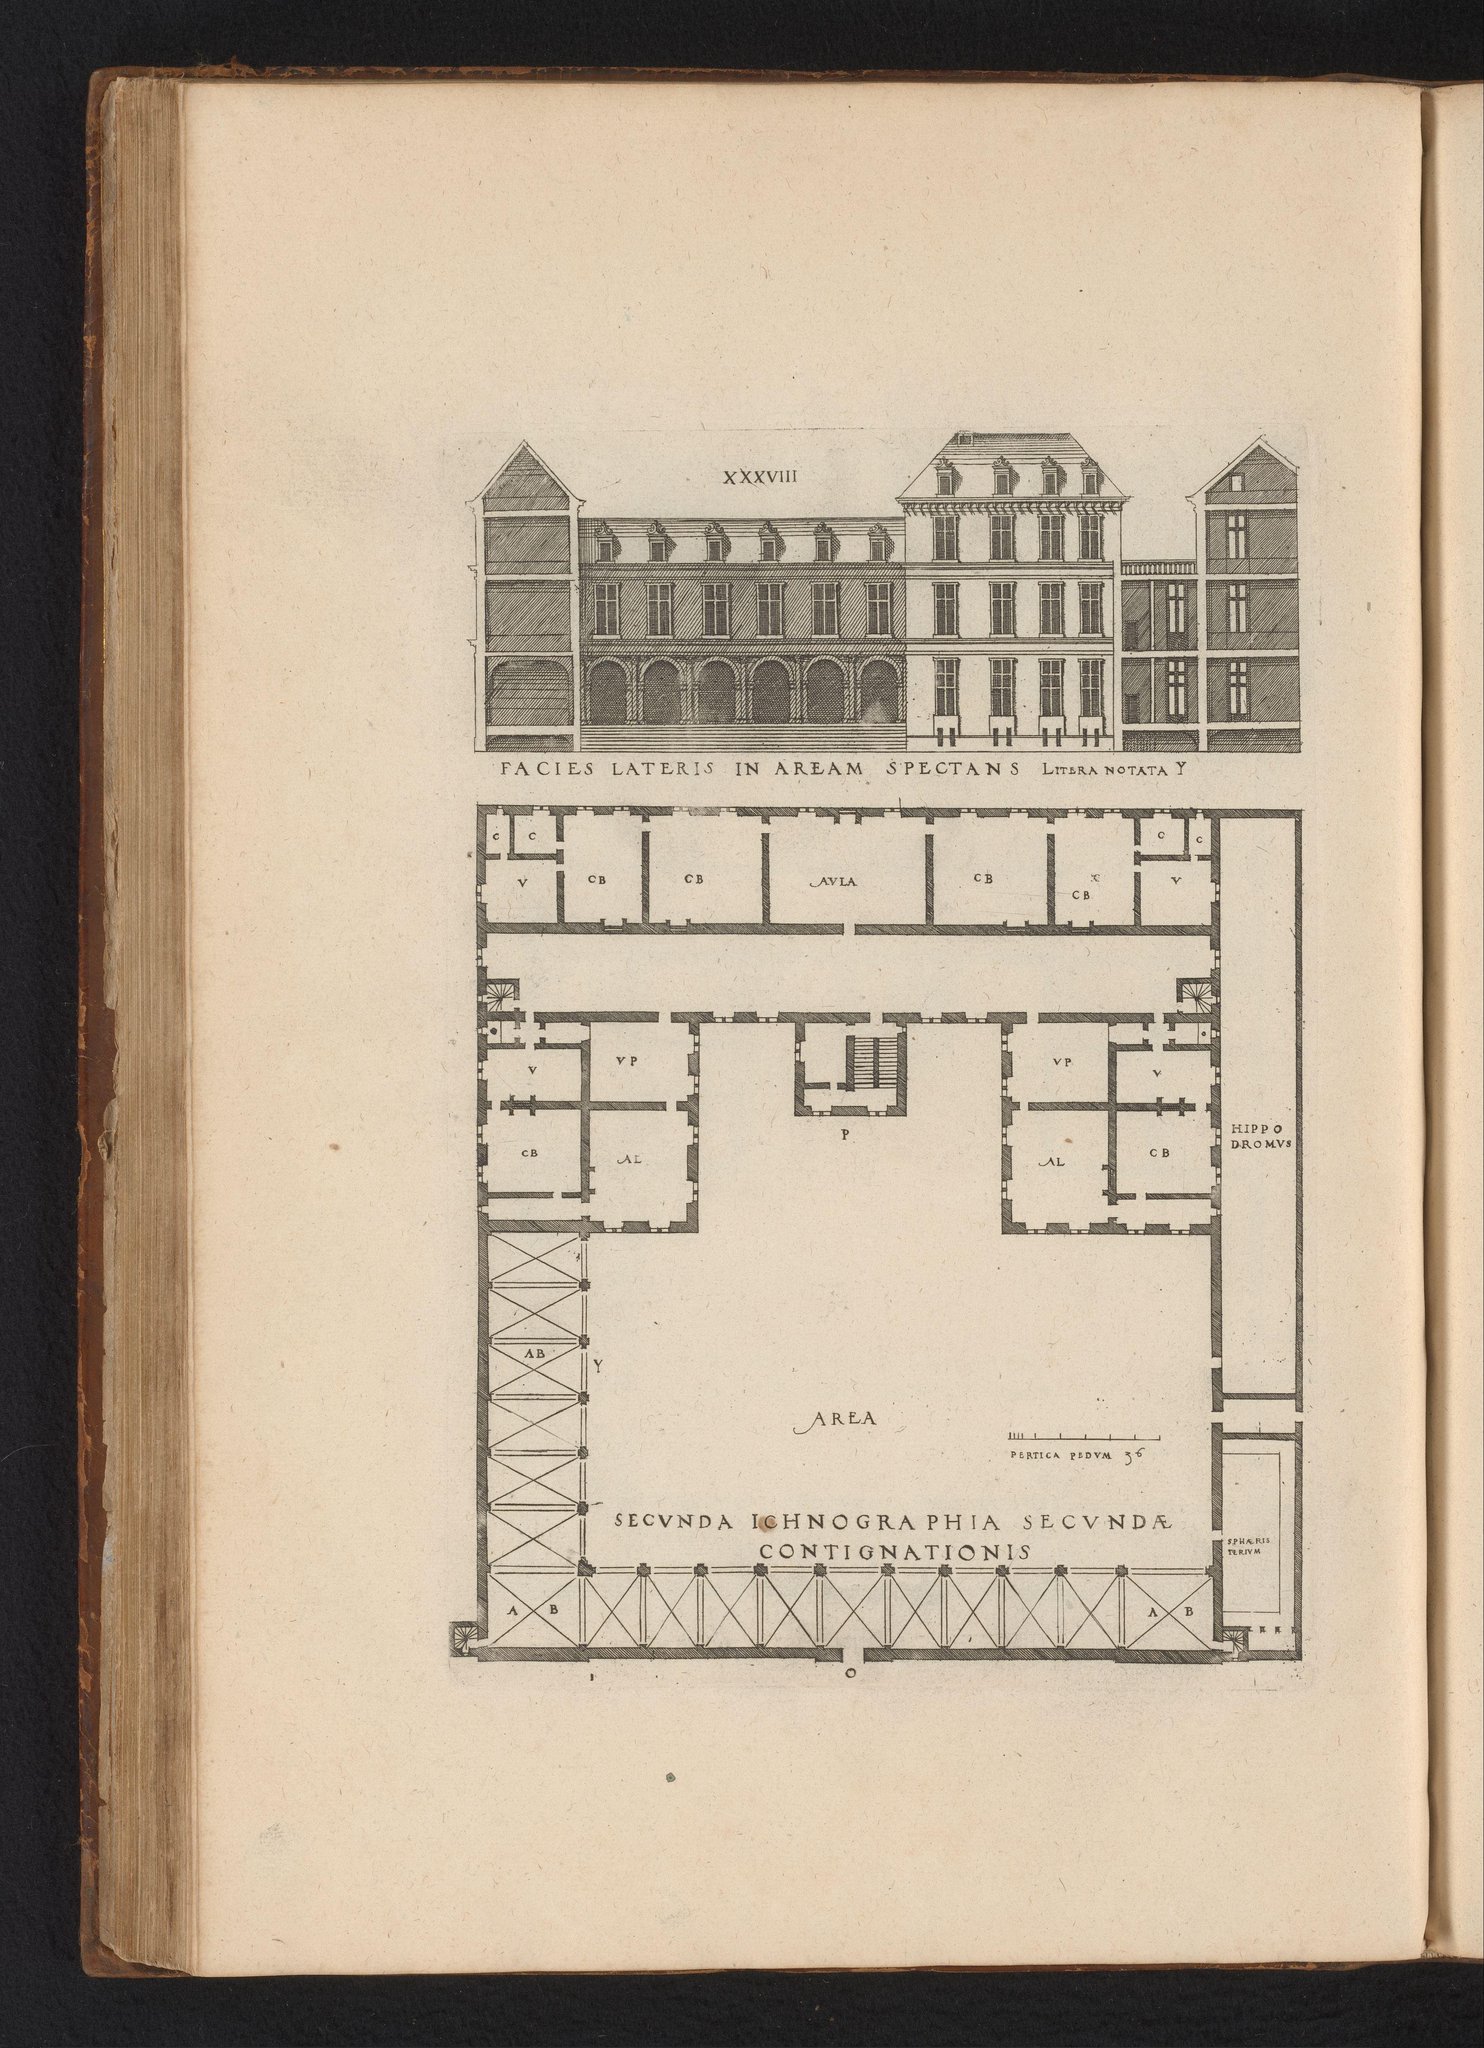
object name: ornament print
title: Doorsnede en plattegrond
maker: jacques androuet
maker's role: draughtsman, print maker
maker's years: 1515-1584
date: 1559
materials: paper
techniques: etching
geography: paris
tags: façade (of house or building), section ~ architectural design or model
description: Doorsnede en plattegrond. Aanzicht en plattegrond van architectuur. Genummerd: XXXVIII. Onderdeel van 'De architectura Iacobi Androuetii du Cerceau' (1559): 69 etsen met 171 voorstellingen van architectuur en ornamentiek.